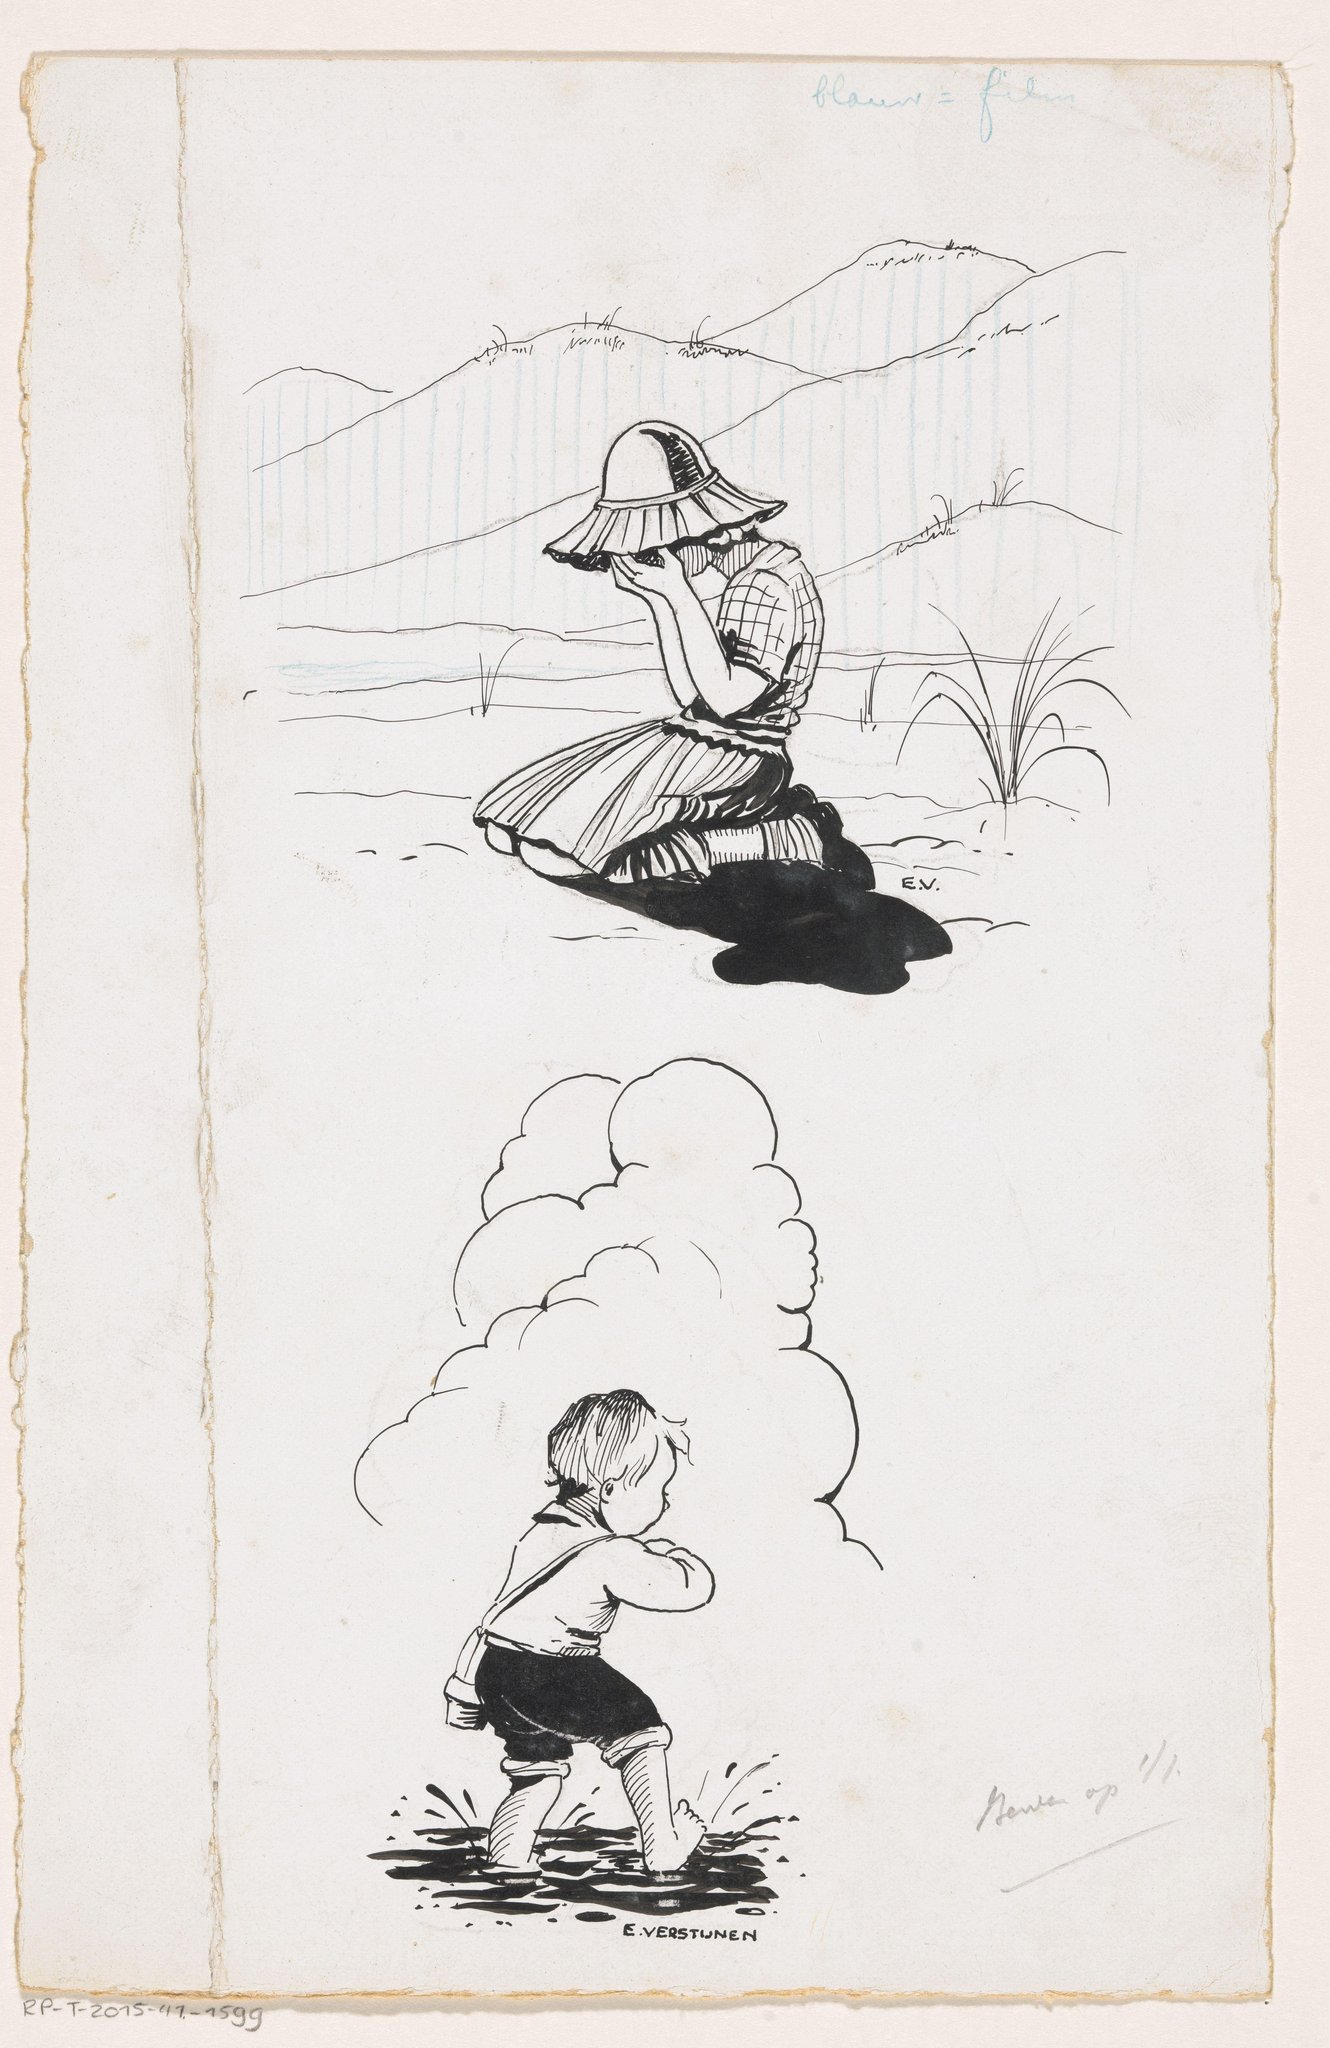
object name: drawing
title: Huilend meisje en jongen spelend in het water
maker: elly verstijnen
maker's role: draughtsman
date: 1900-1930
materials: ink, paper, pencil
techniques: brush, pen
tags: weeping, child and nature (games and plays), mountains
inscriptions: :, collector's mark: Lugt 2228, signature: ‘E.V./ E. VERSTIJNEN’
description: In een kaal landschap met bergen zit een meisje op haar knieën. Ze heeft een hoed op en houdt haar handen voor haar ogen. Onder een jongen met opgerolde broekspijpen die in het water speelt.